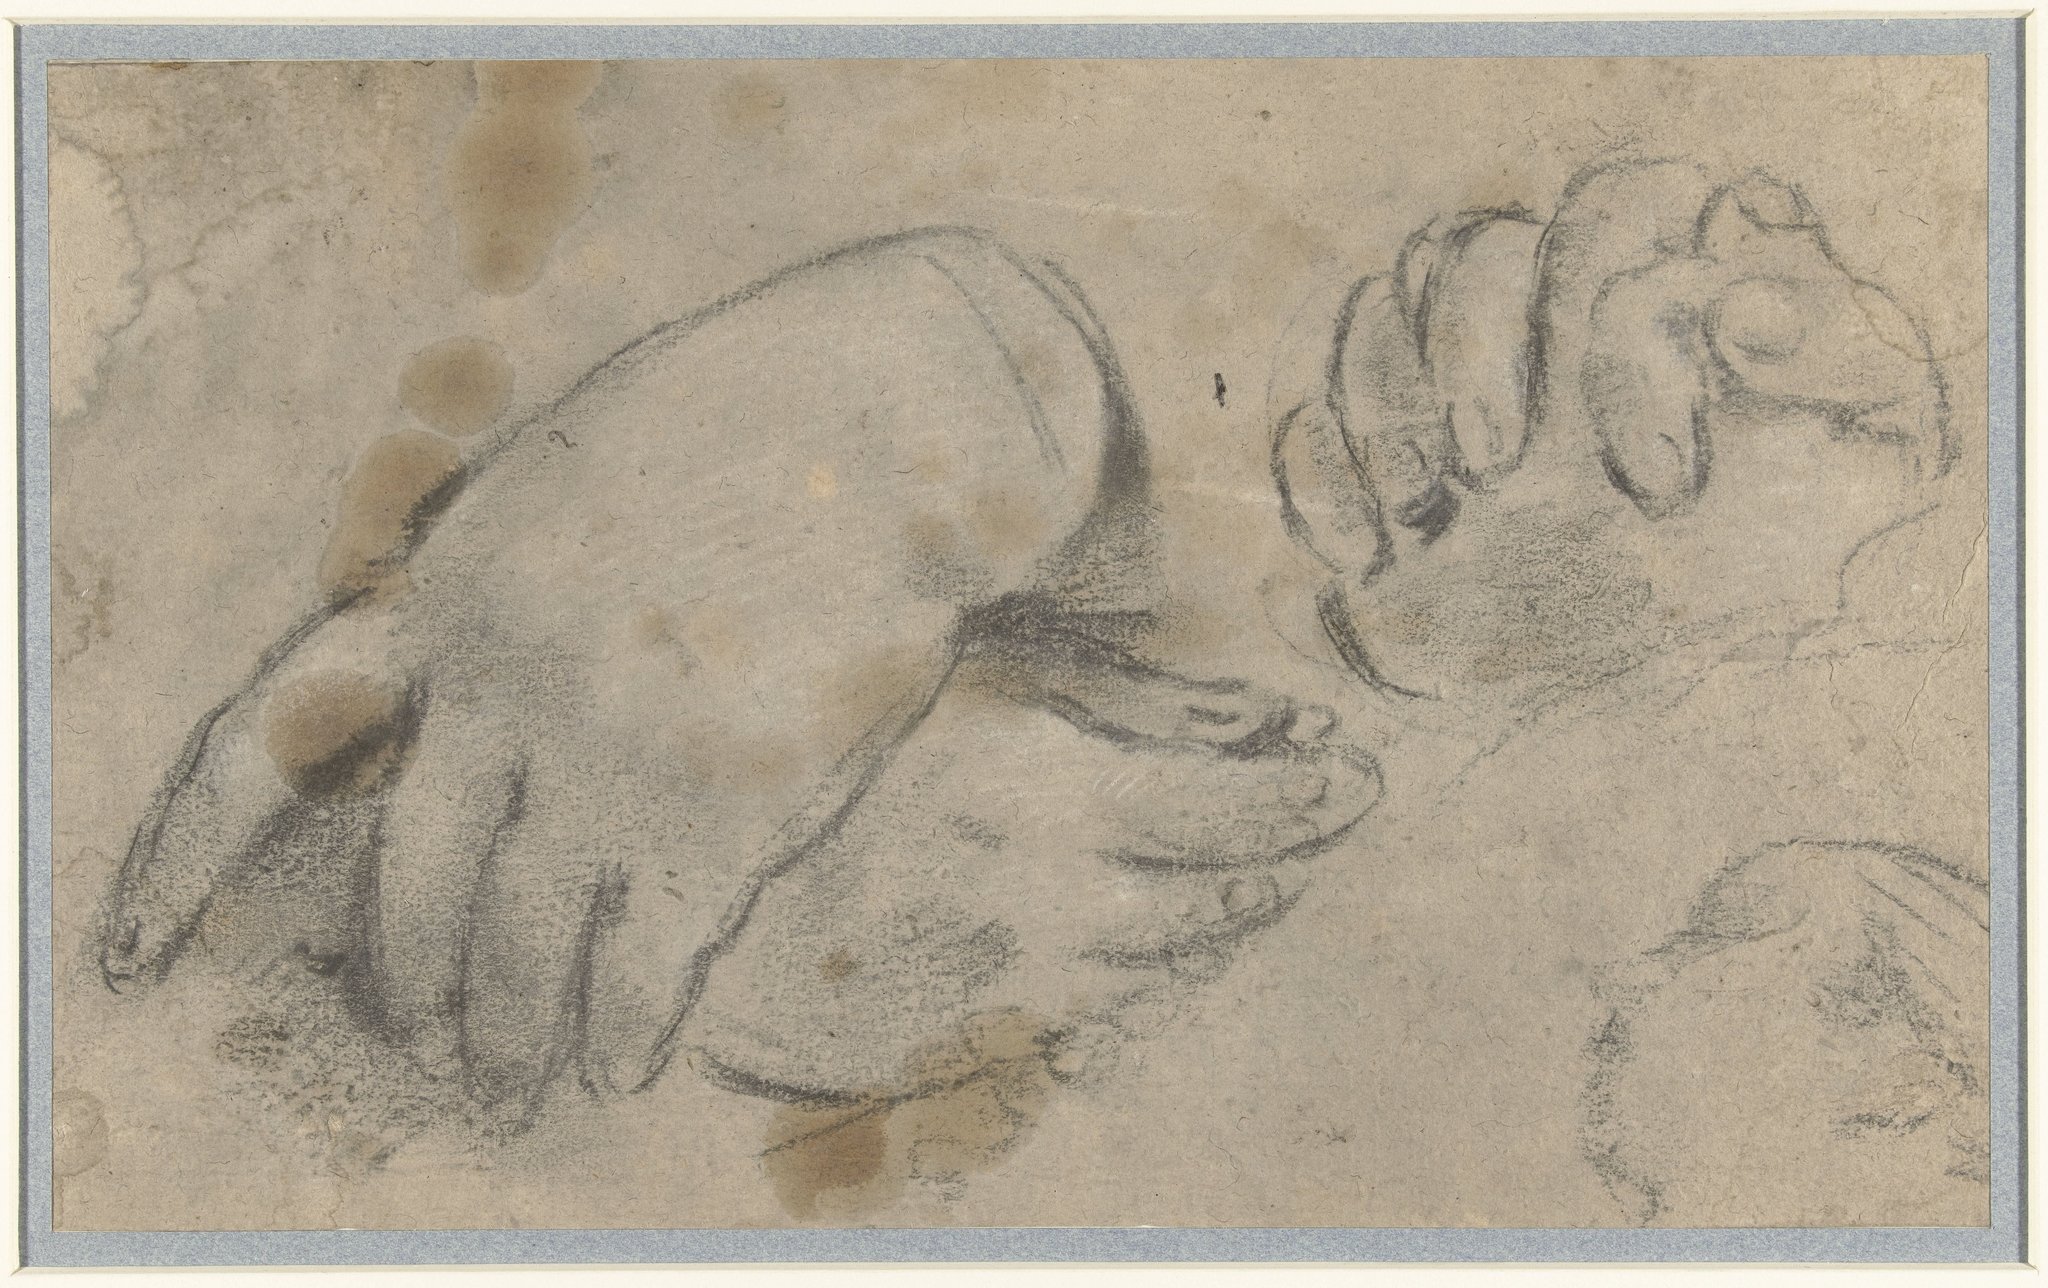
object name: drawing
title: Studieblad met handen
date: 1587-1660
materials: chalk, paper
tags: hands folded with fingers knit, hands on top of each other